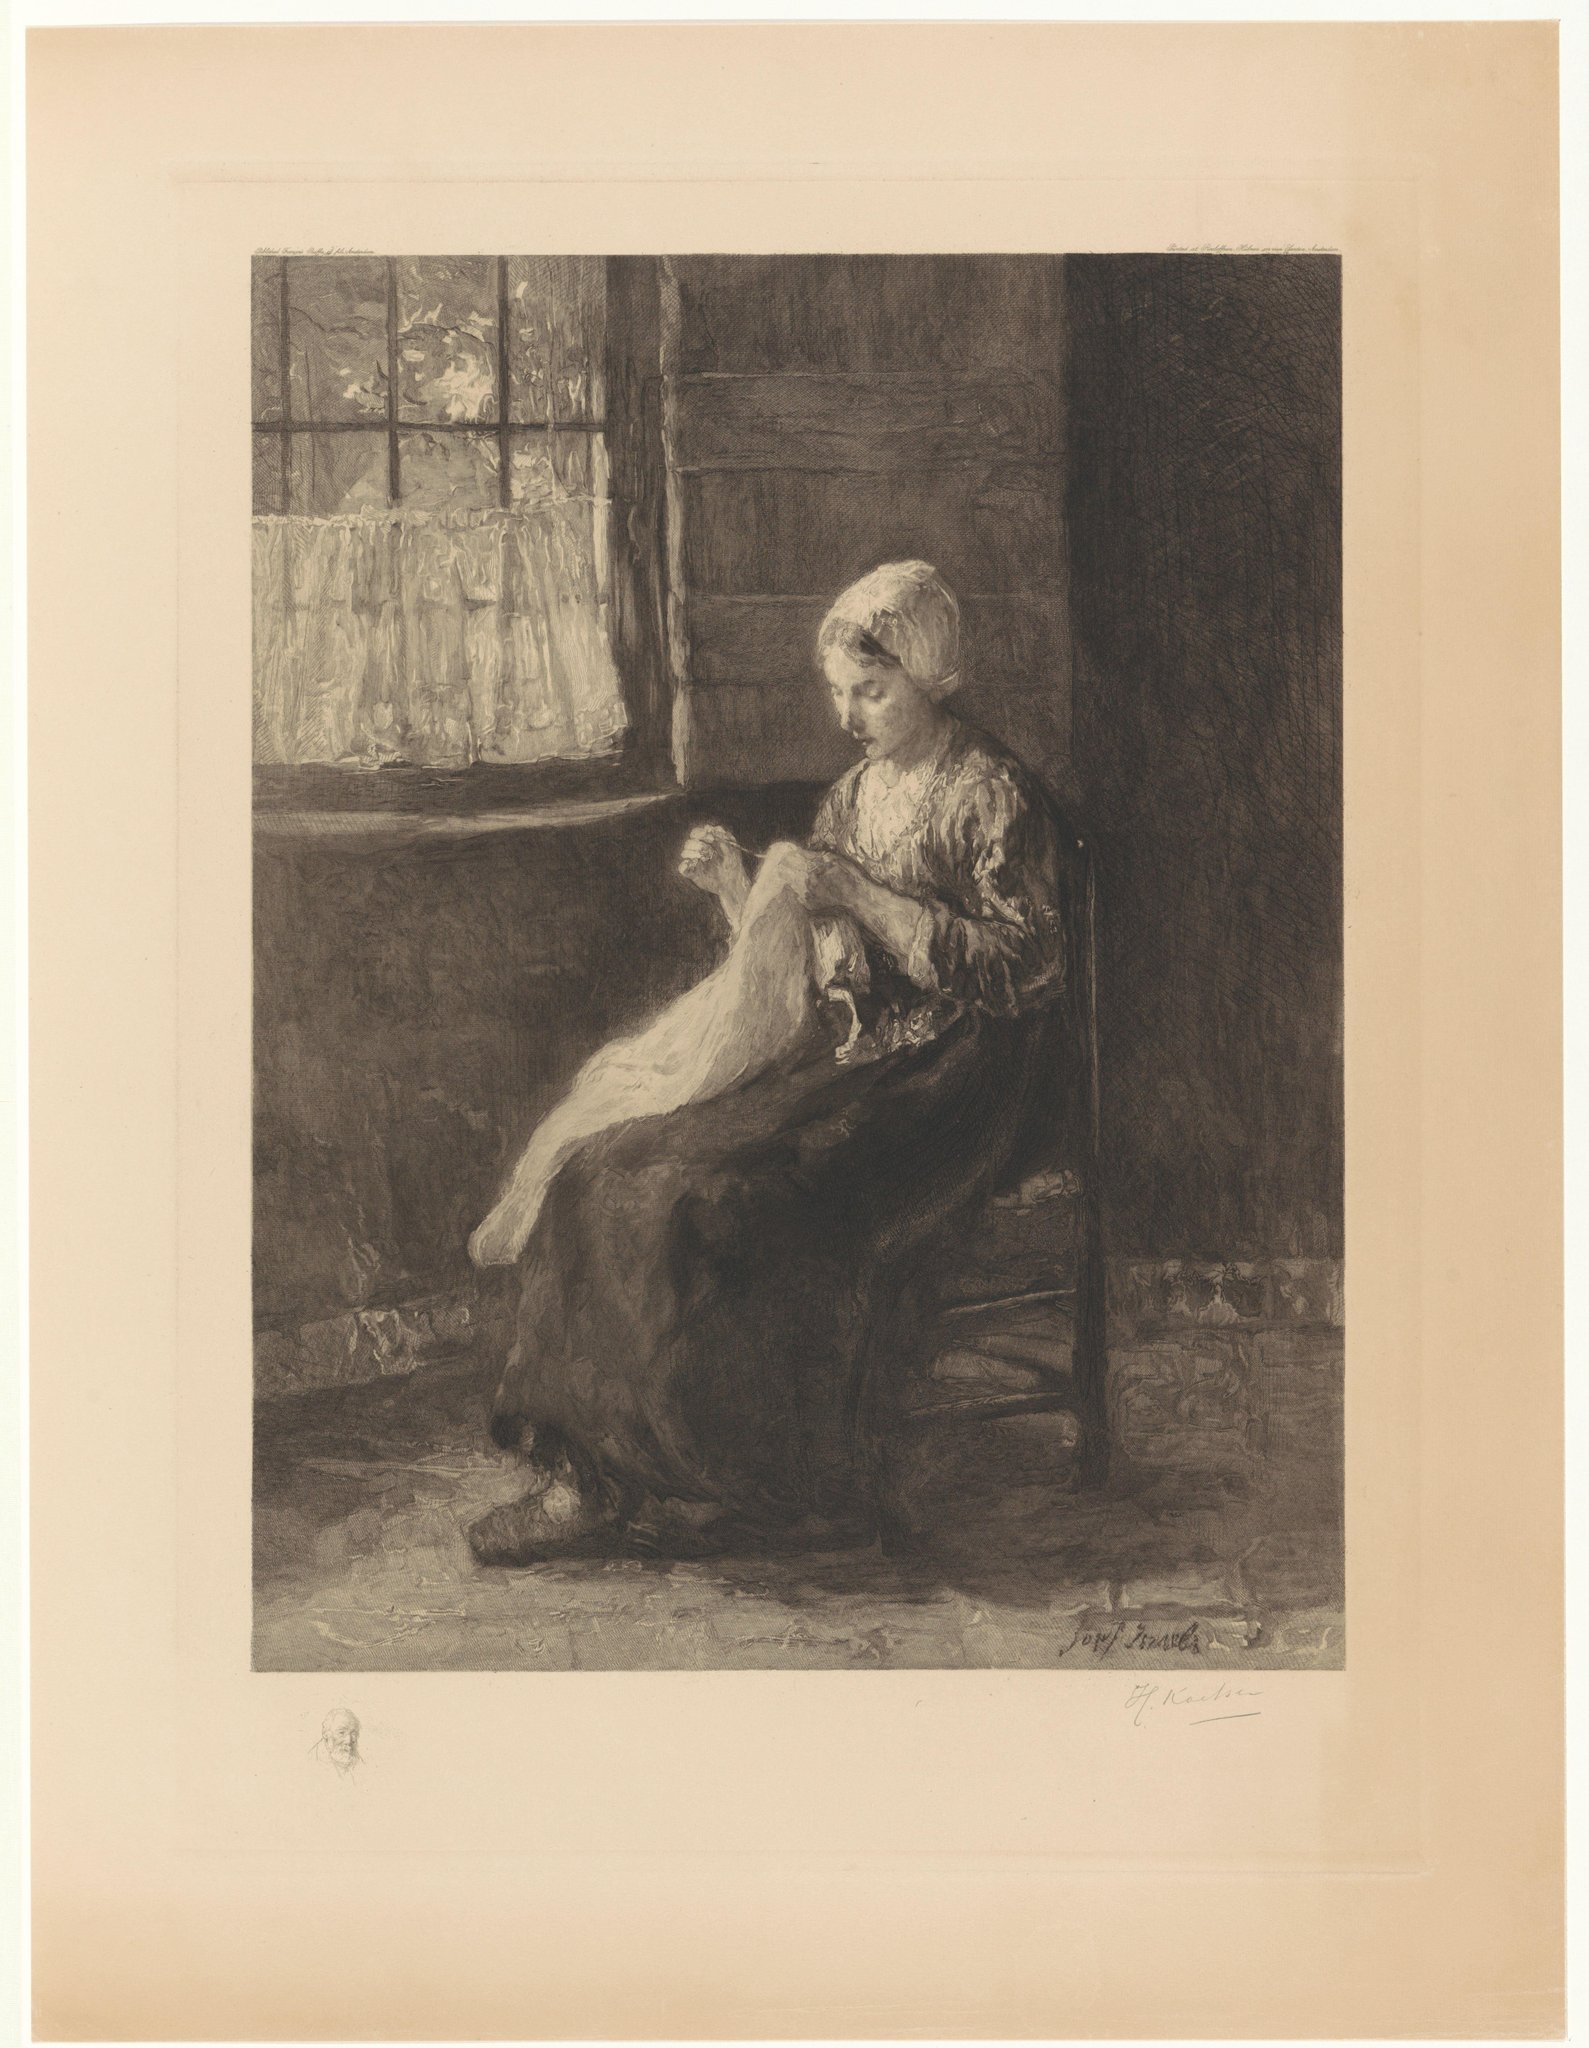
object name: print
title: Naaistertje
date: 1894-1934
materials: paper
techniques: etching, intaglio, roulette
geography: netherlands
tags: sewing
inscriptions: collector's mark: Lugt 2228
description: In een vertrek zit een meisje op een stoel naast een venster een kledingstuk te verstellen. In de marge het hoofd van een man.